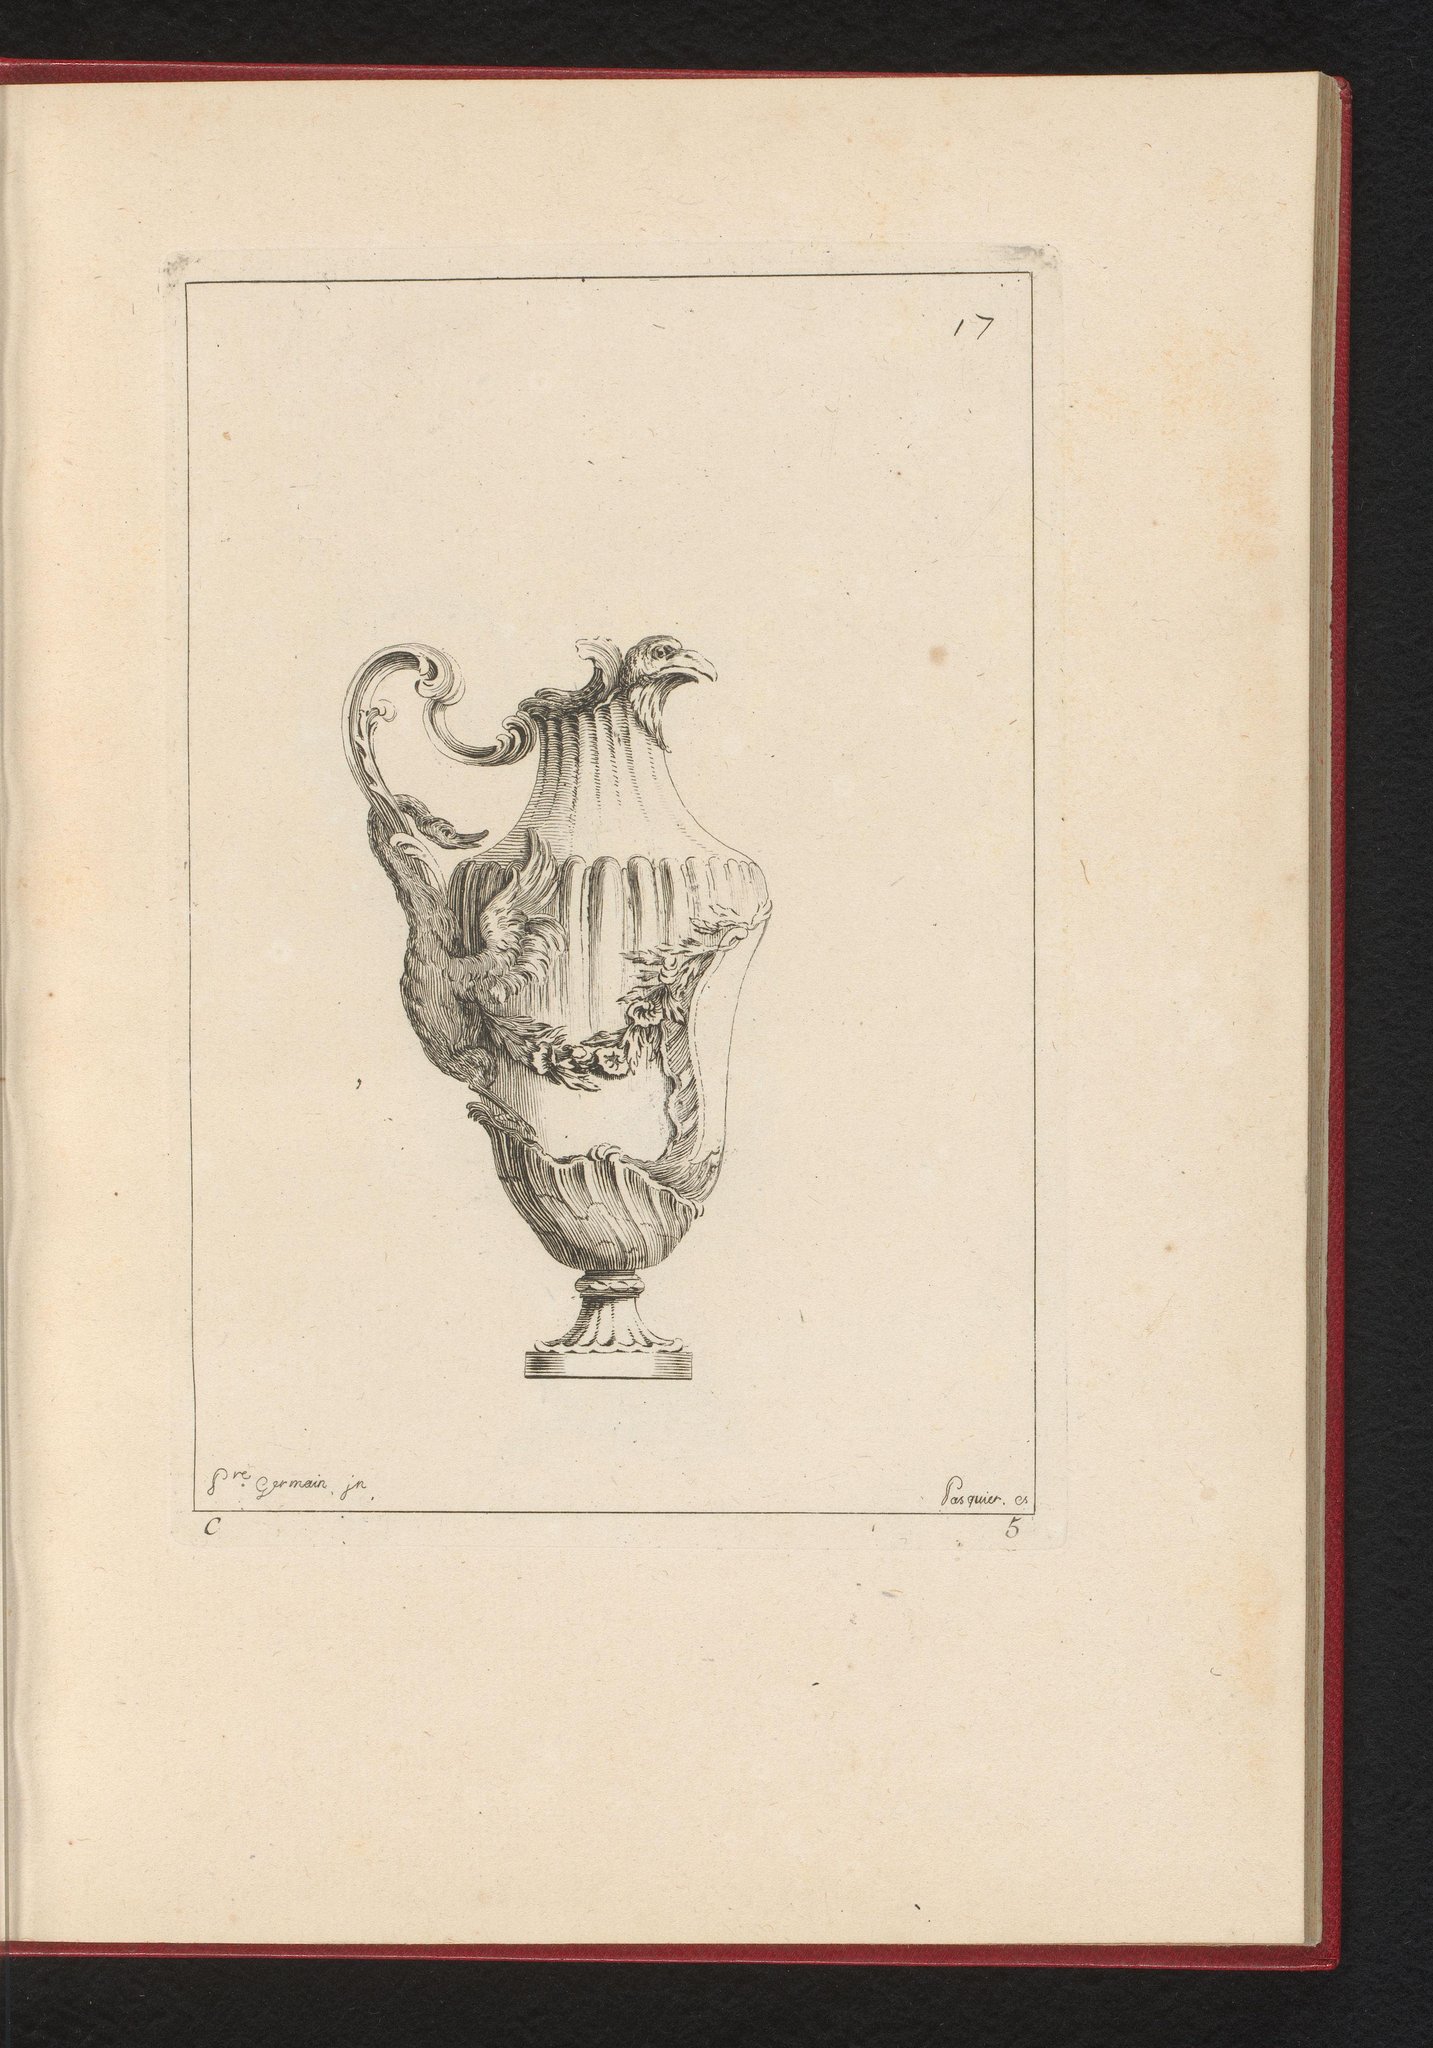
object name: album leaf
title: Elements d'orfevrerie divisés en deux parties de cinquante feuilles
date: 1748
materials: paper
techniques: etching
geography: paris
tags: jeweller, goldsmith, silversmith, container of ceramics: jar, jug, pot, vase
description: Een aantal van de objecten in deze reeks heeft een eigen ondertitel, die verwijst naar genummerde 'cahiers' (afleveringen) waarin de prenten werden uitgegeven. Het is onduidelijk welke objecten recies bij welke aflevering horen. Daarom is die ondertitel enkel verwerkt bij de prent waarop die voorkomt.